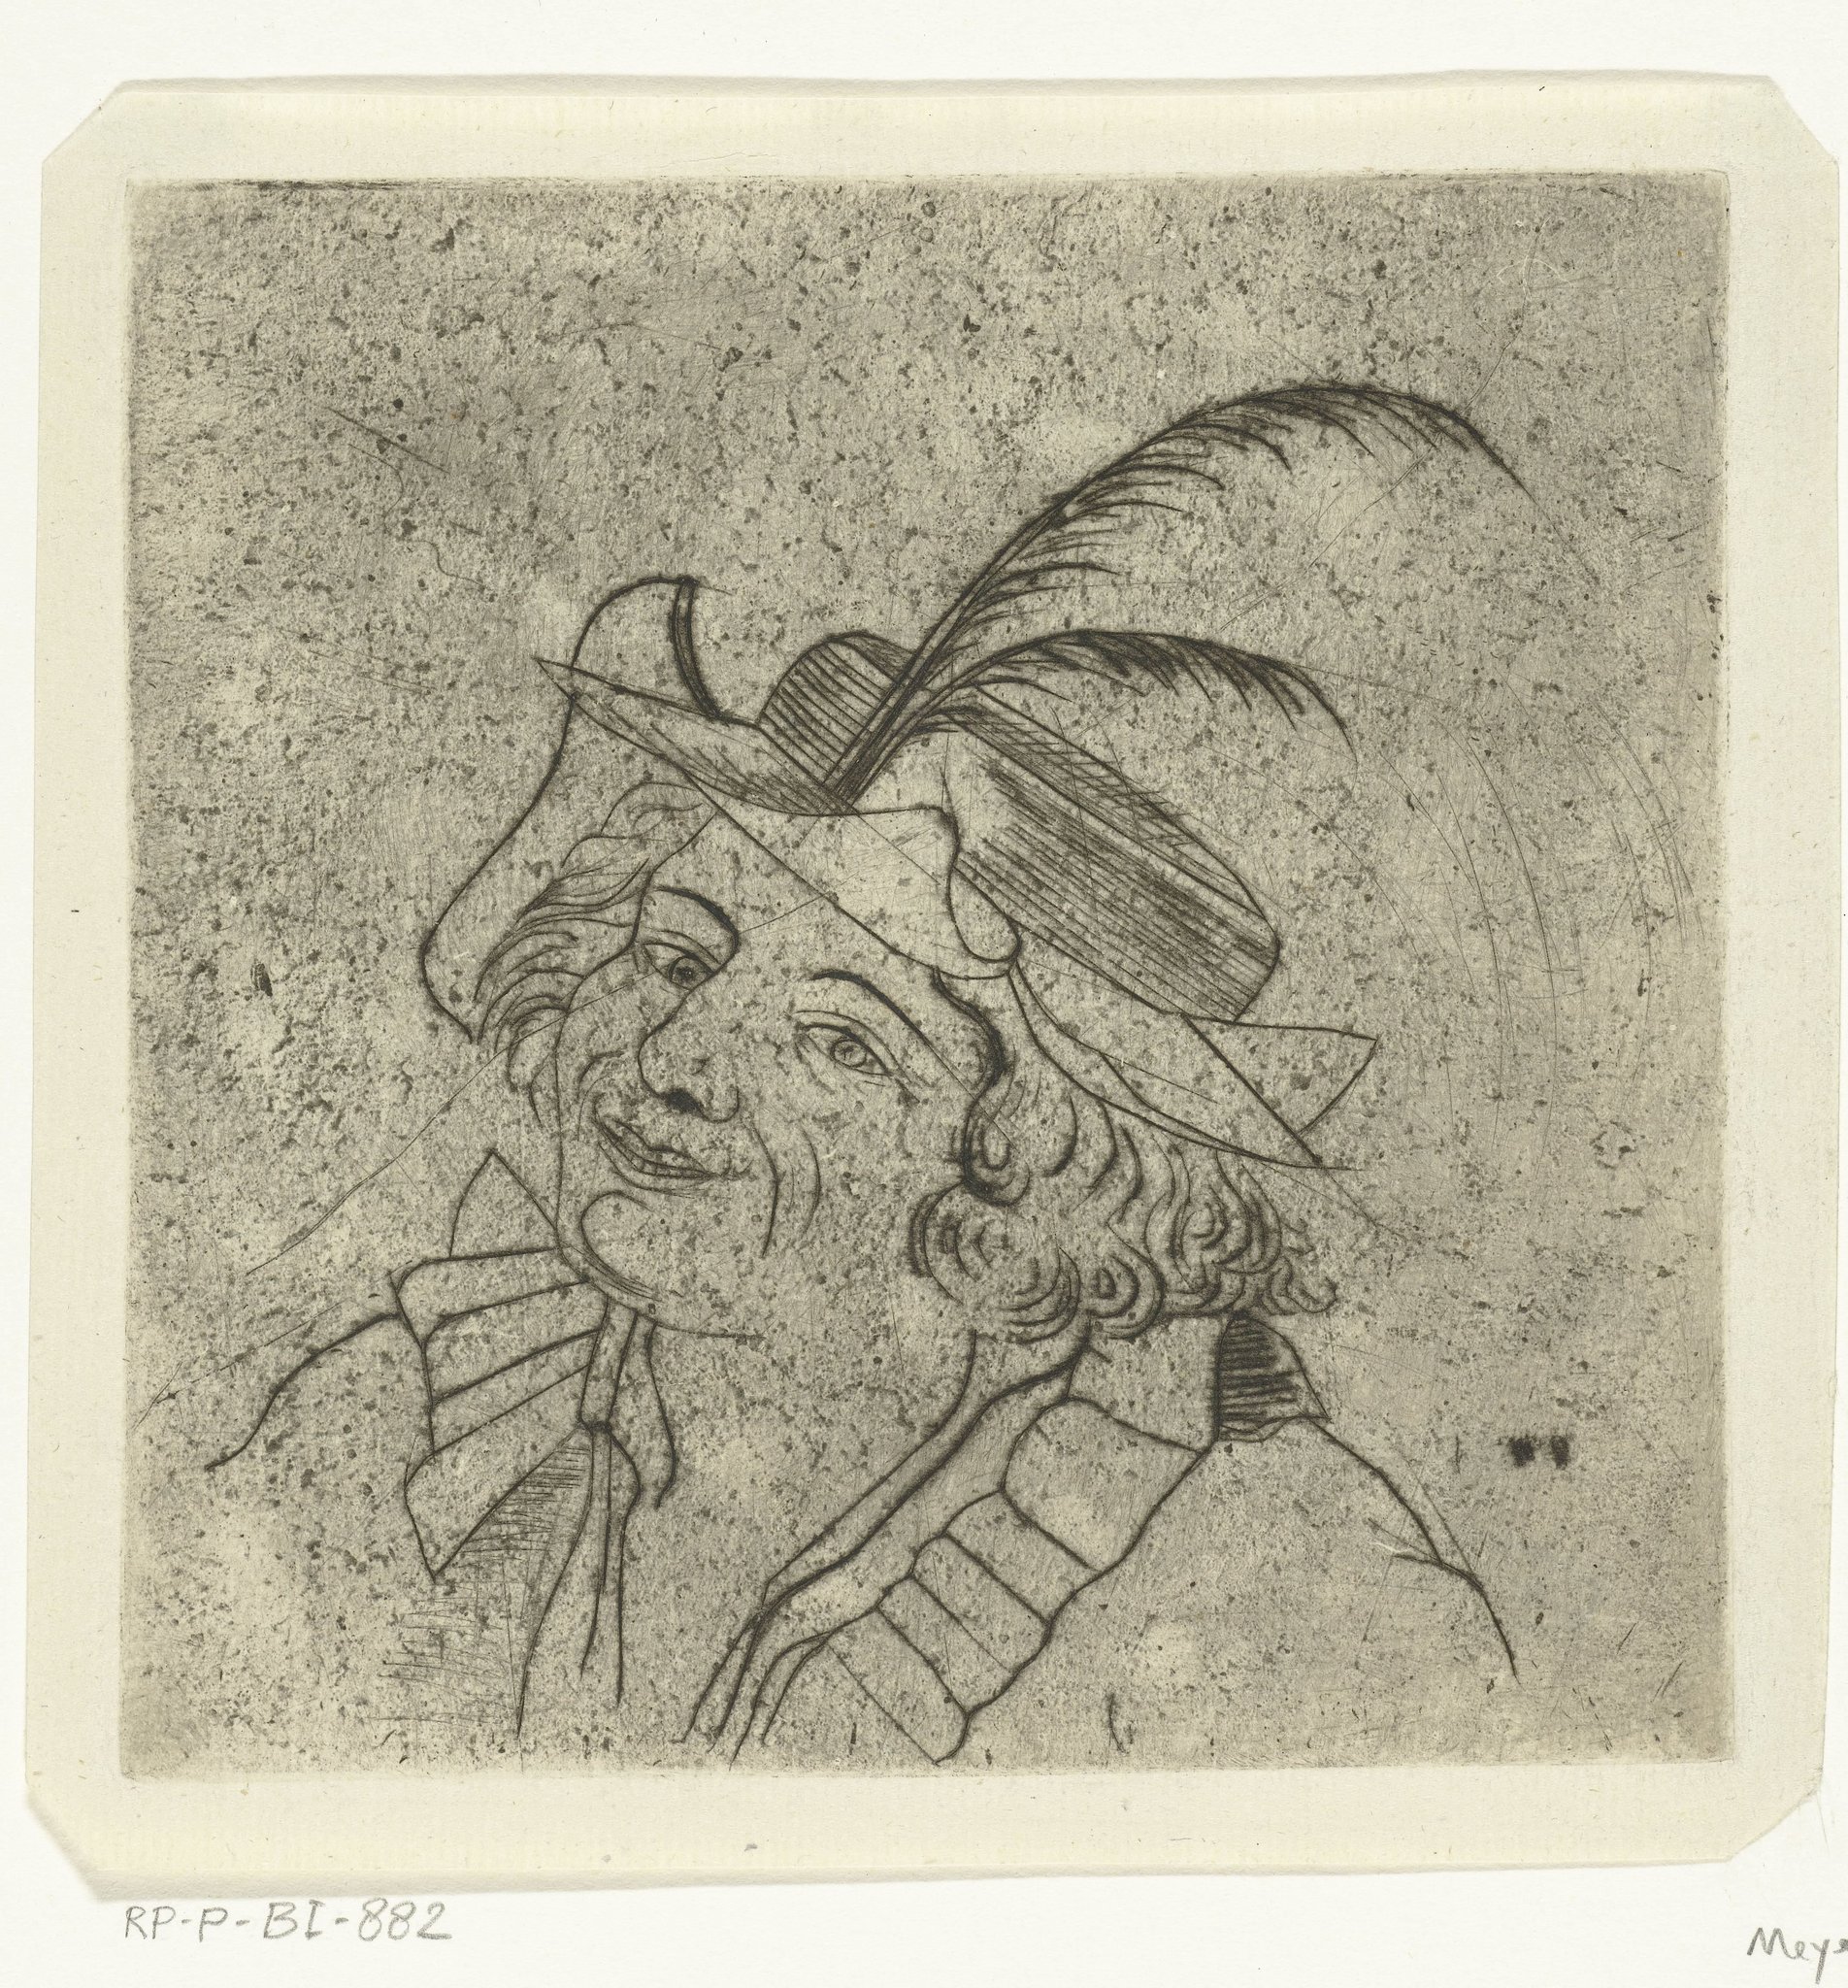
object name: print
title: Hoofd van lachende man met hoed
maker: jonkheer isaac lambertus cremer van den berch van heemstede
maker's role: print maker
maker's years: 1811-1879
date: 1821-1879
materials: paper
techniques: drypoint, etching, intaglio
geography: netherlands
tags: laughing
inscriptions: collector's mark: Lugt 2228